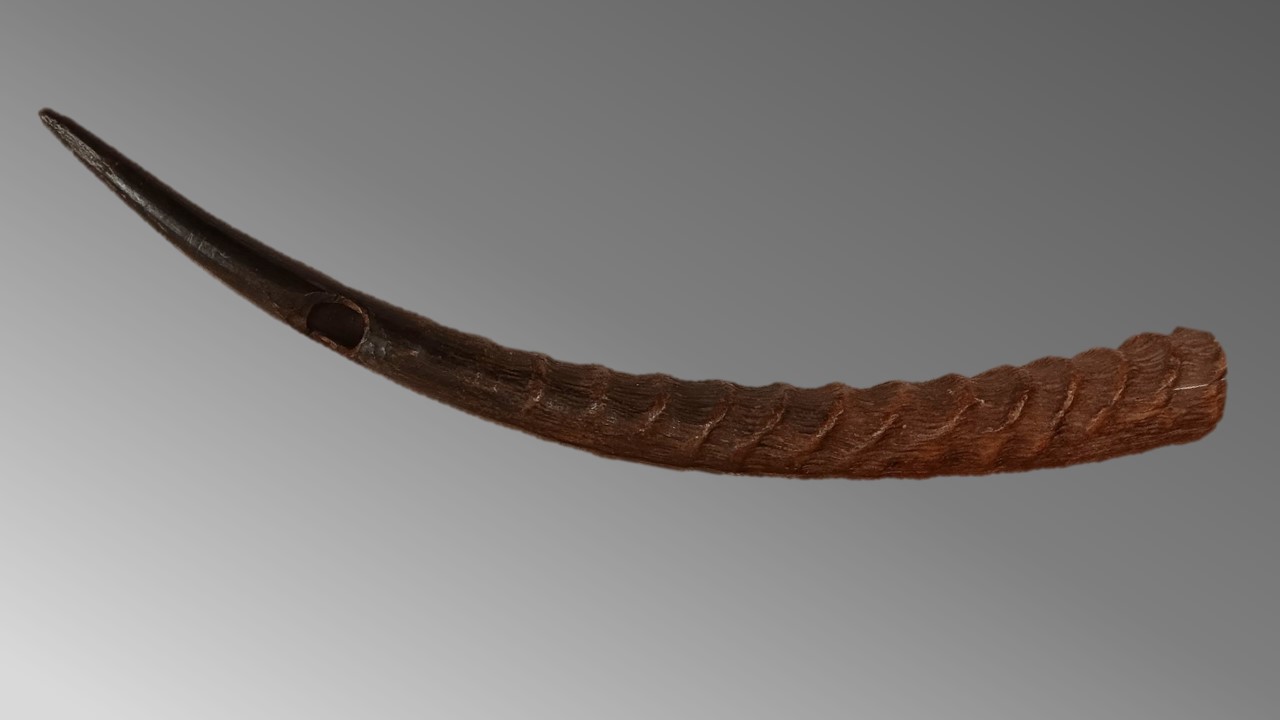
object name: horn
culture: african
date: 1867-1900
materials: horn